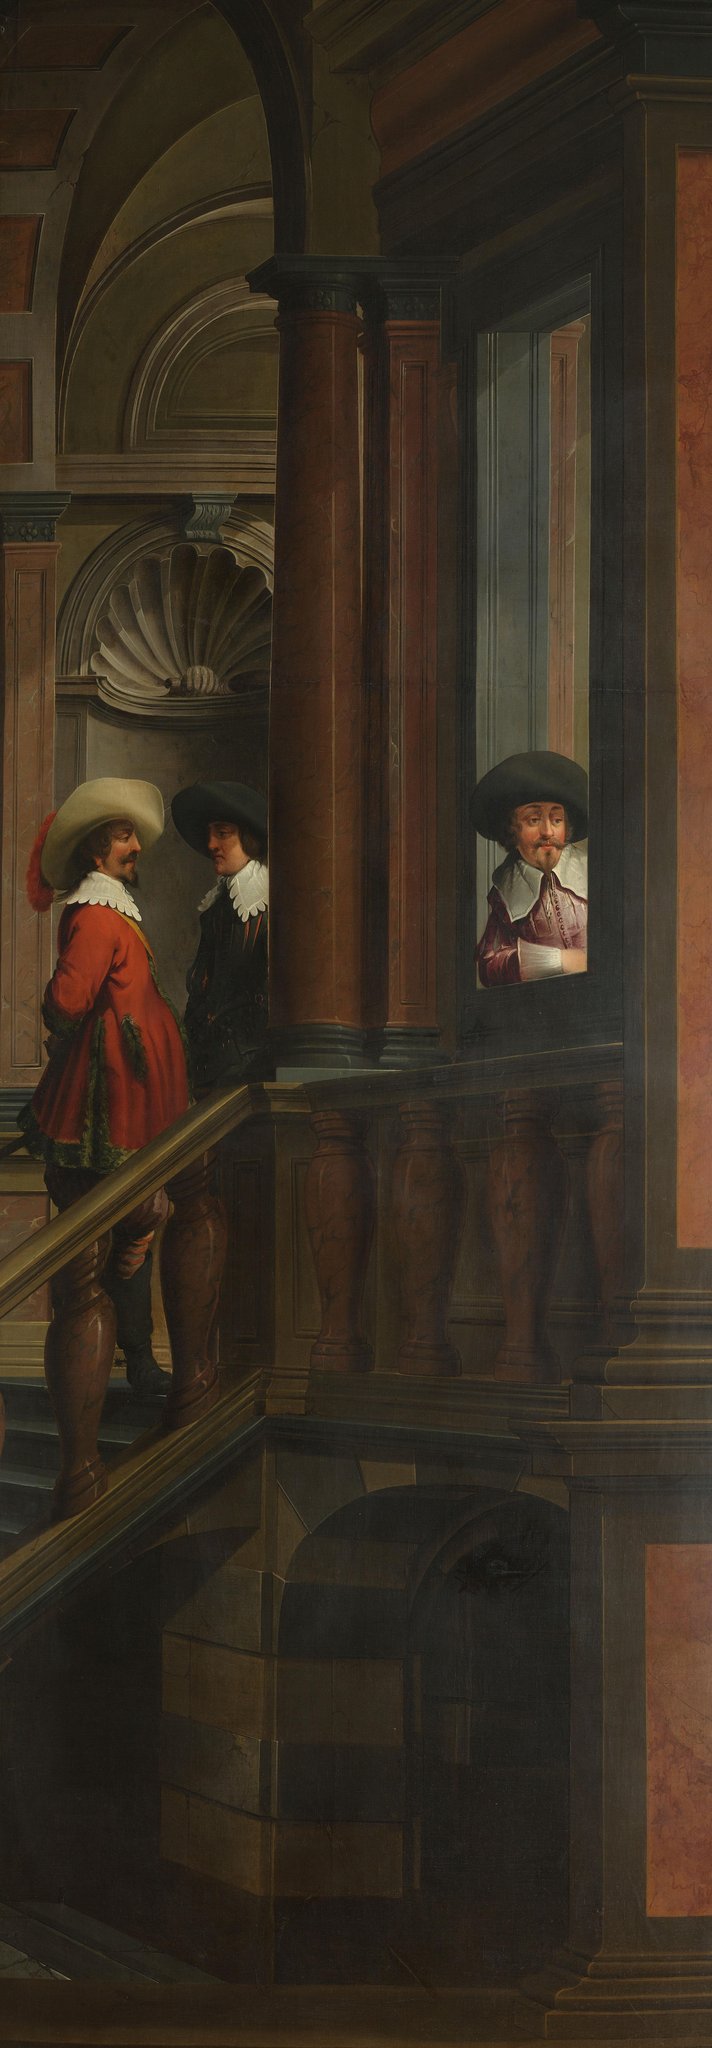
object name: painting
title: A Seven-Part Decorative Sequence: An Outdoor Stairway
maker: dirck van delen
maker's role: painter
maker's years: 1604-1671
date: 1630-1632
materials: canvas, oil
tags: palace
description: Onderdeel van een zevendelige kamerbeschildering in vijf stukken met afbeeldingen van een interieur, twee galerijen en twee buitentrappen, bevolkt met talrijke personen. Het betreft hier de rechterhelft van de voorstelling met drie figuren op een buitentrap. (Zie voor de andere helft SK-A-3941)